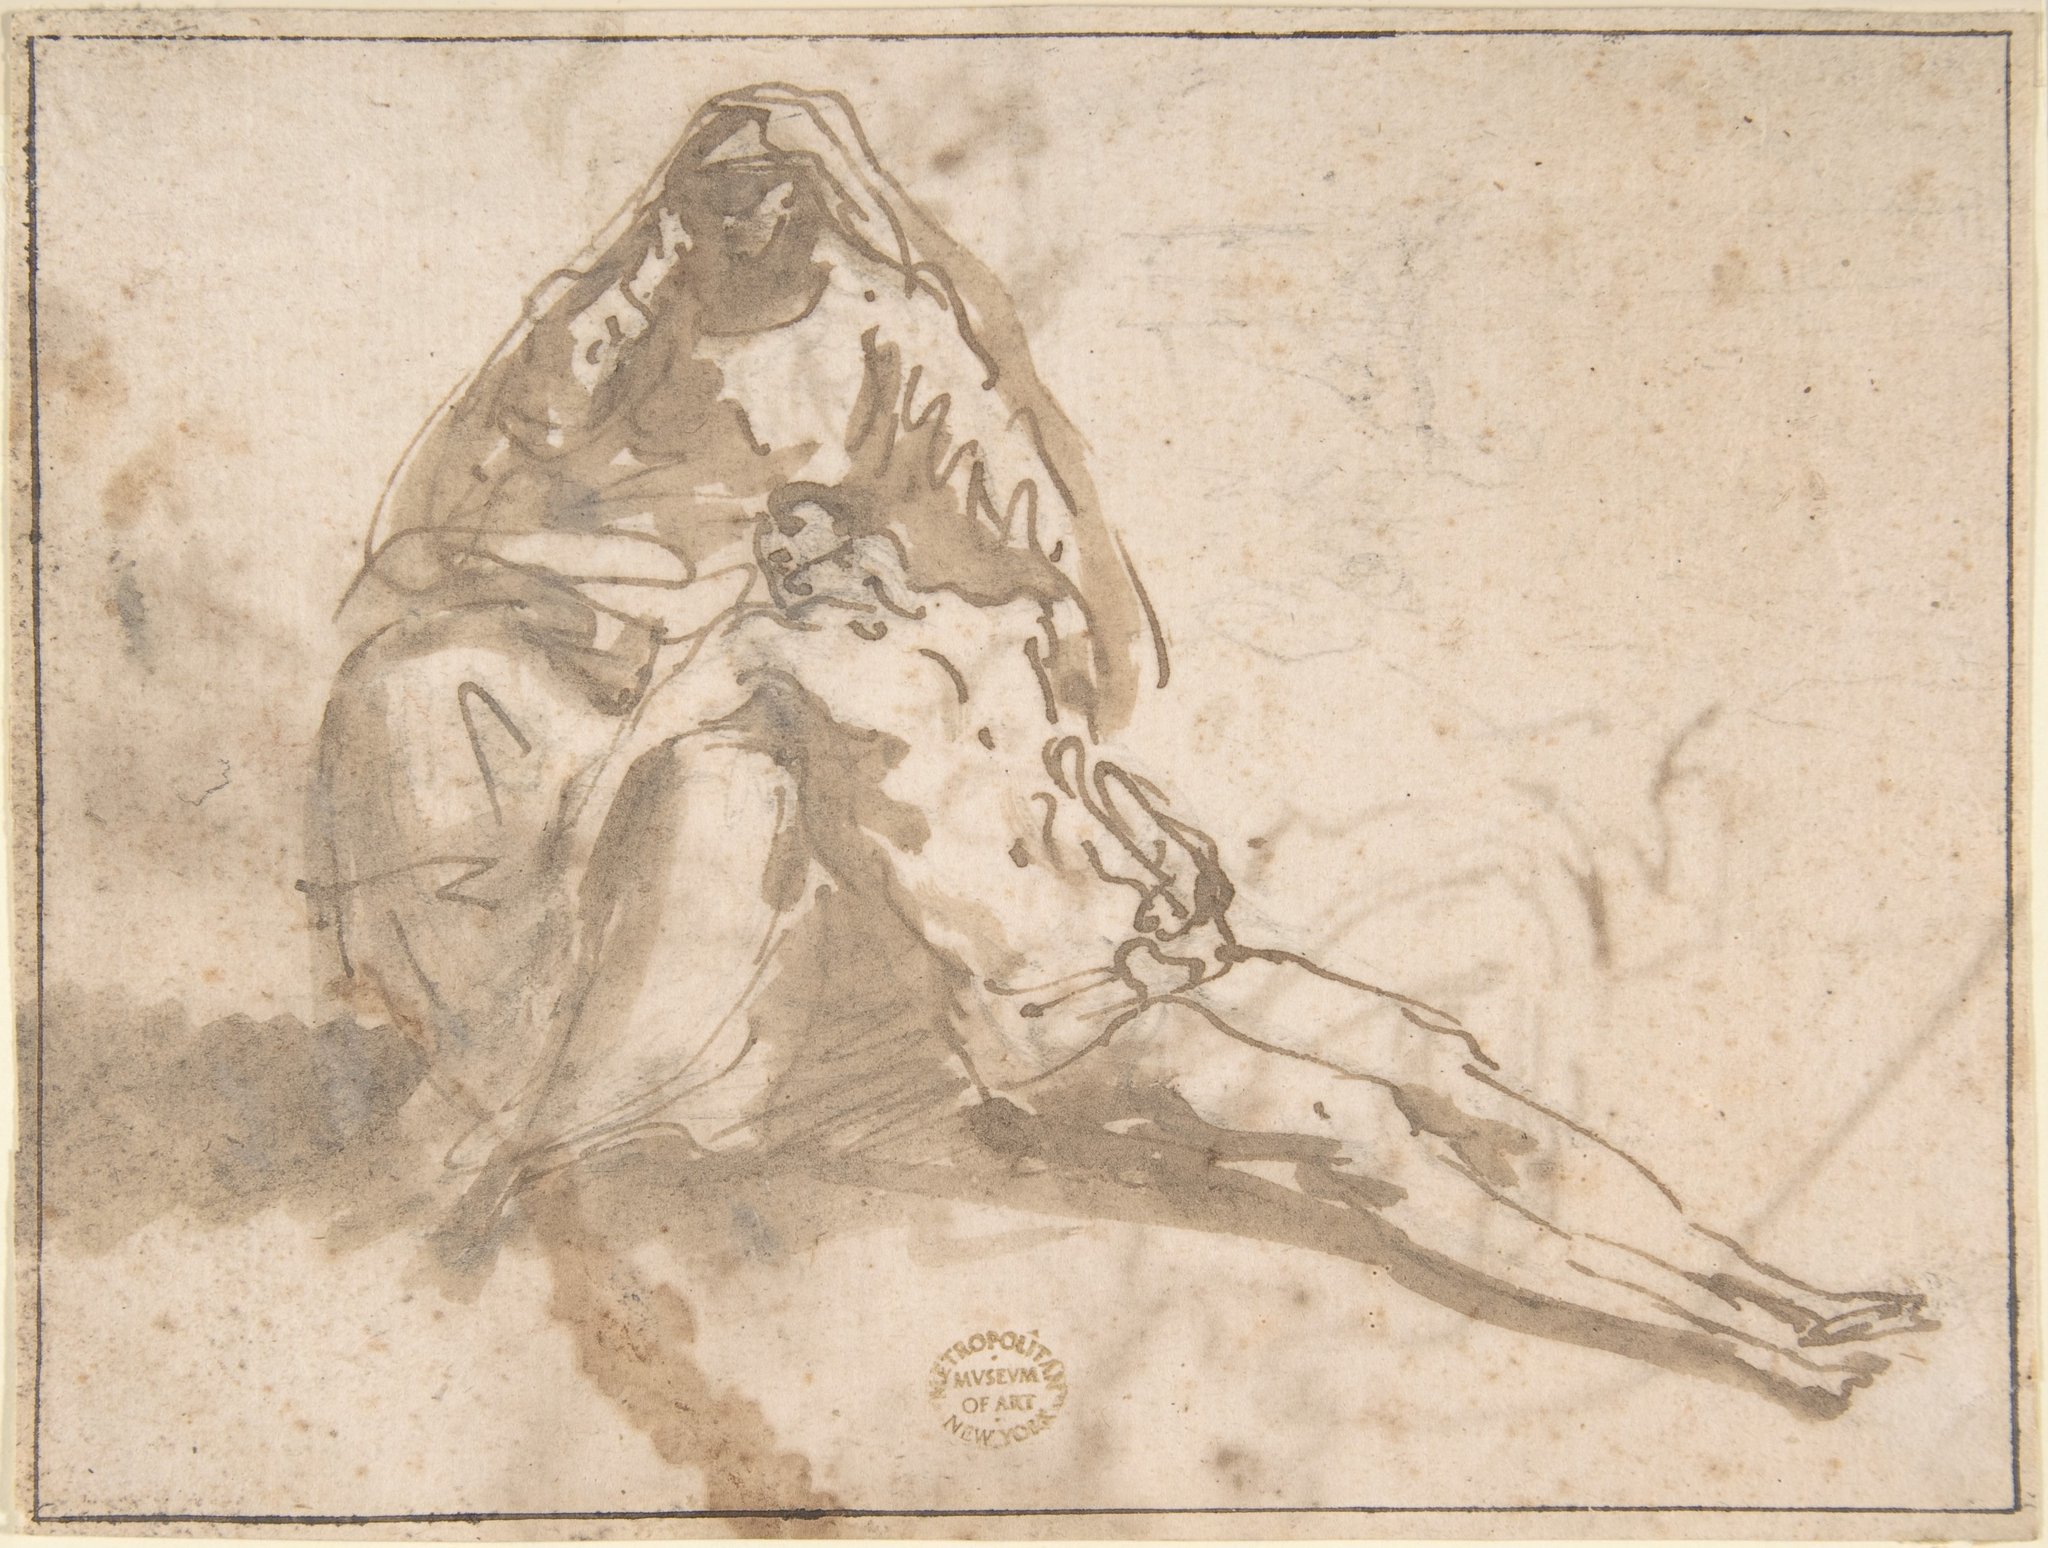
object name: drawing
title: Pietà (recto); Sketches of Kneeling Figures, Putto (verso)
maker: domenico mondo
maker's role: artist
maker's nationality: italian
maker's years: 1732-1806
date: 1760-1806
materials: chalk, ink, paper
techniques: brush, pen, wash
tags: men,women